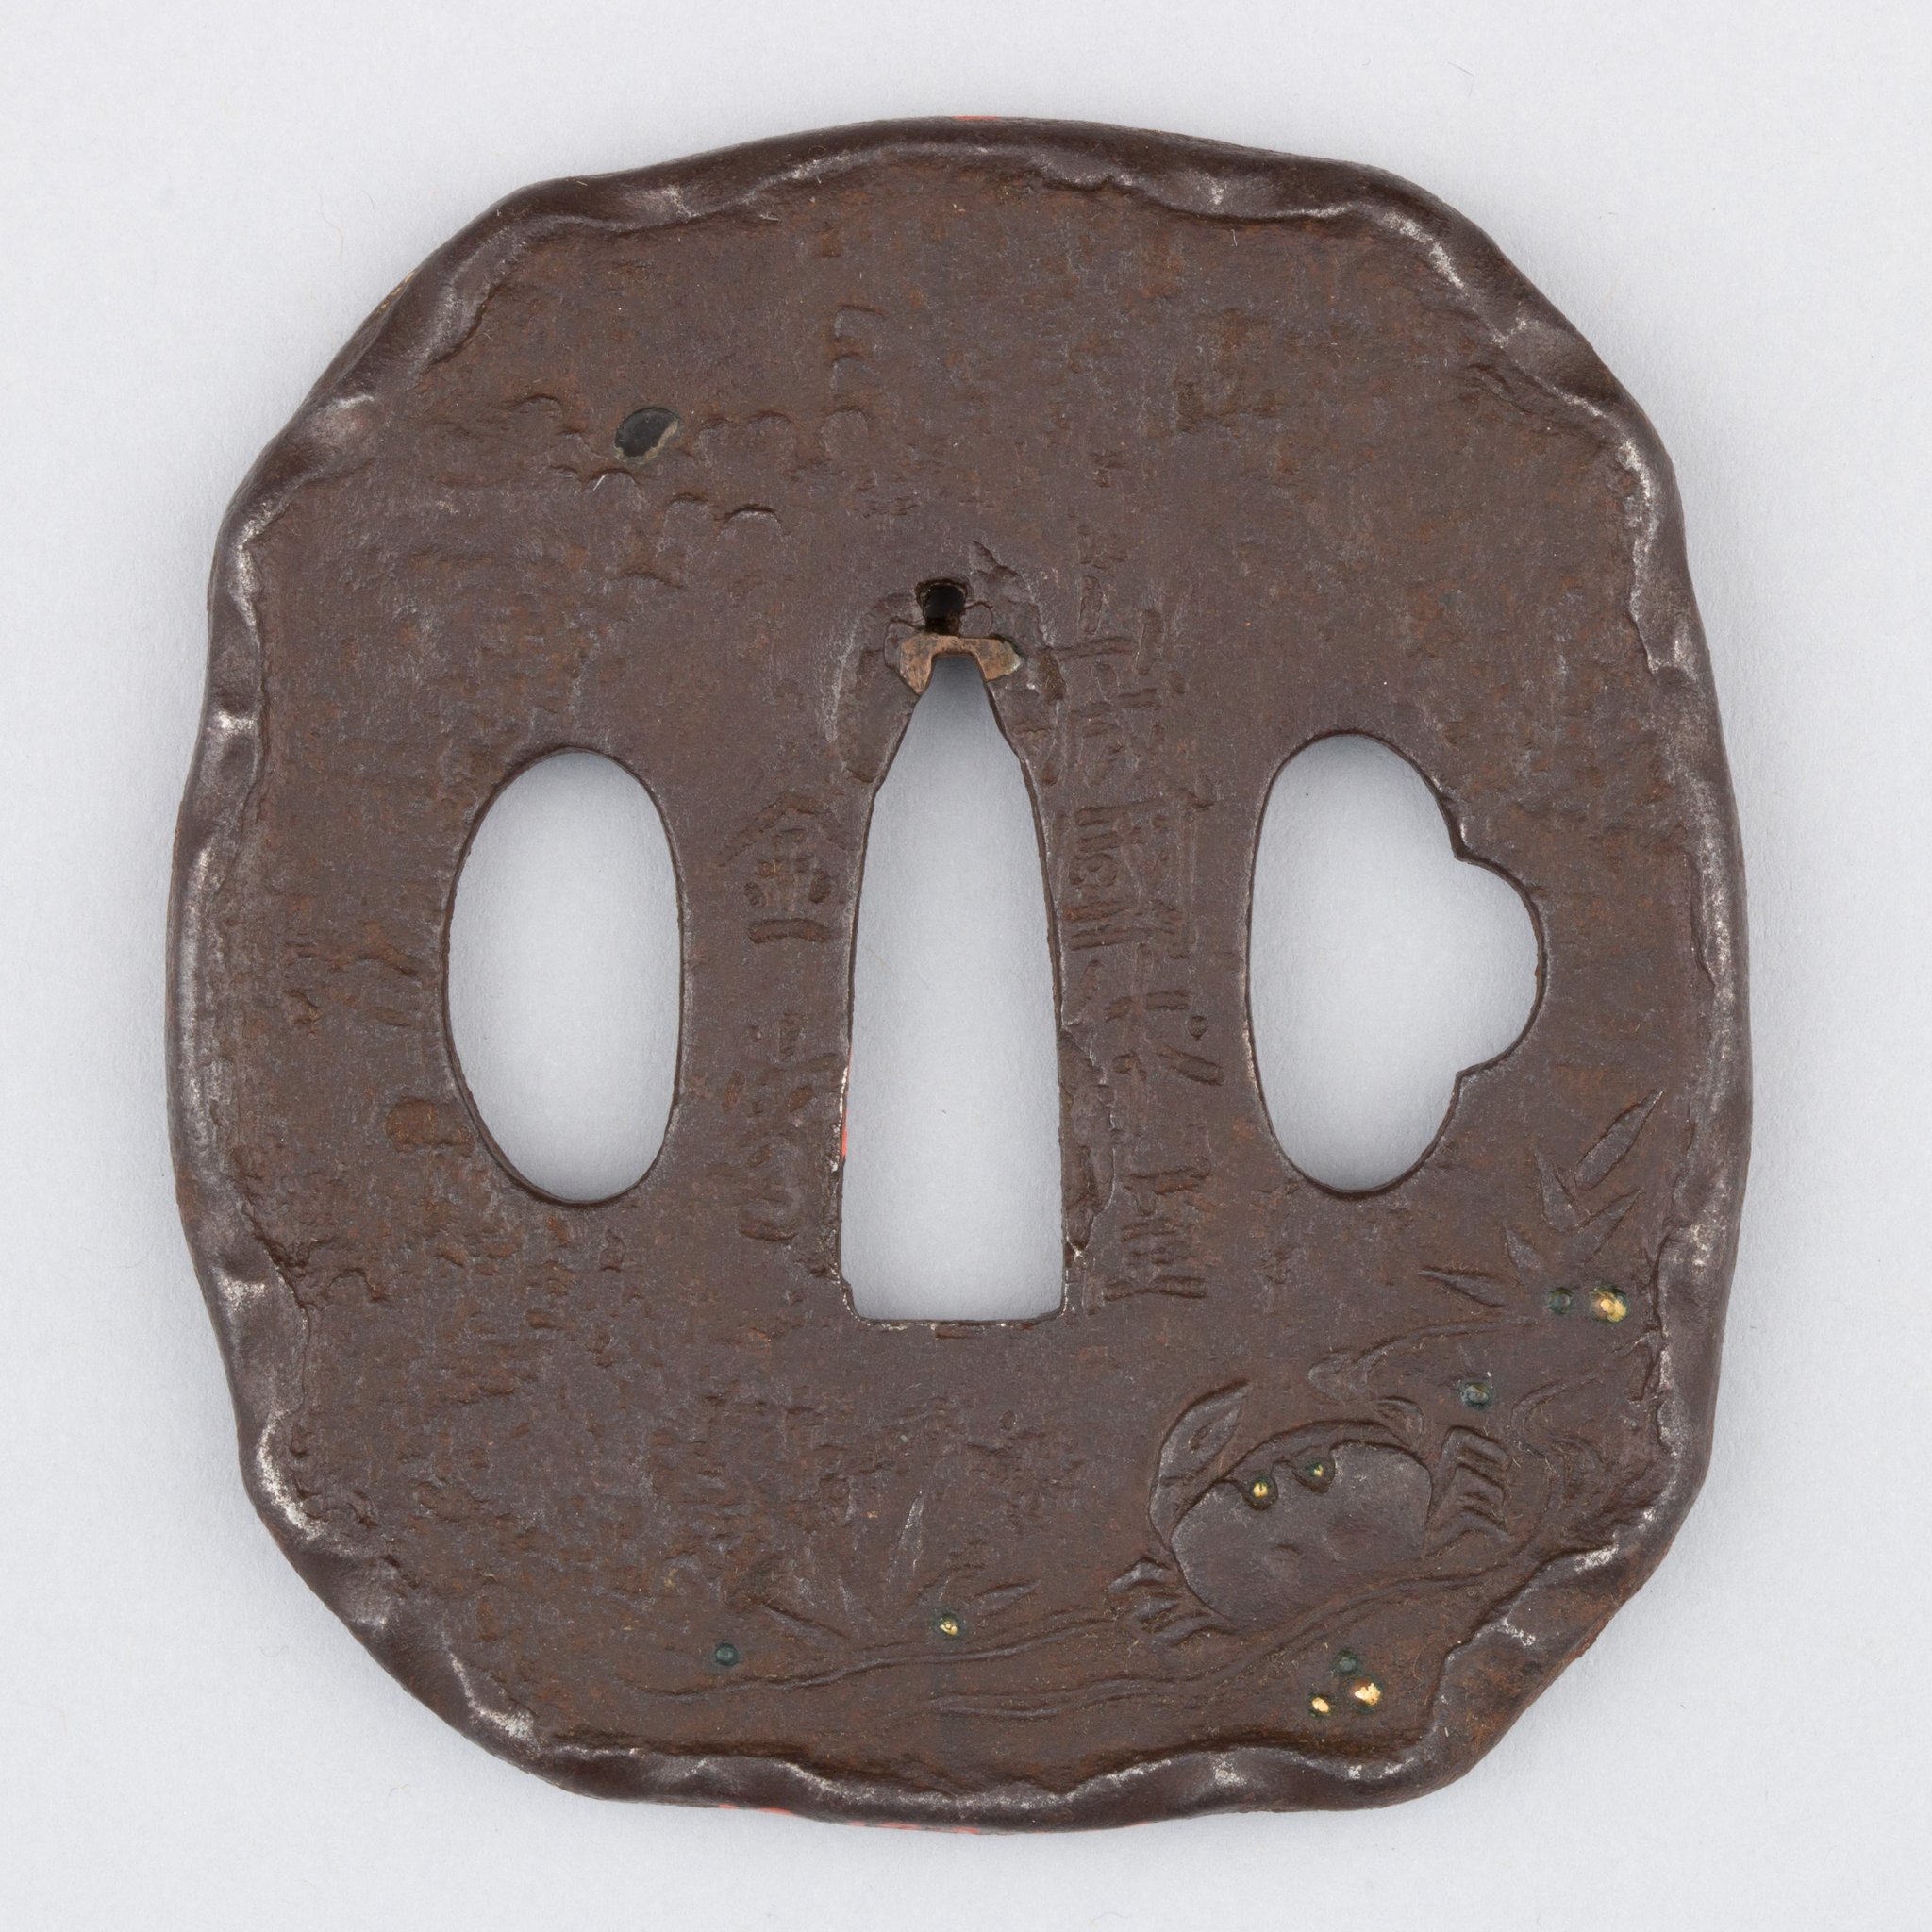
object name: sword guard tsuba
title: Sword Guard (Tsuba)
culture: japanese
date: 1615-1868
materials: copper, iron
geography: japan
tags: crabs